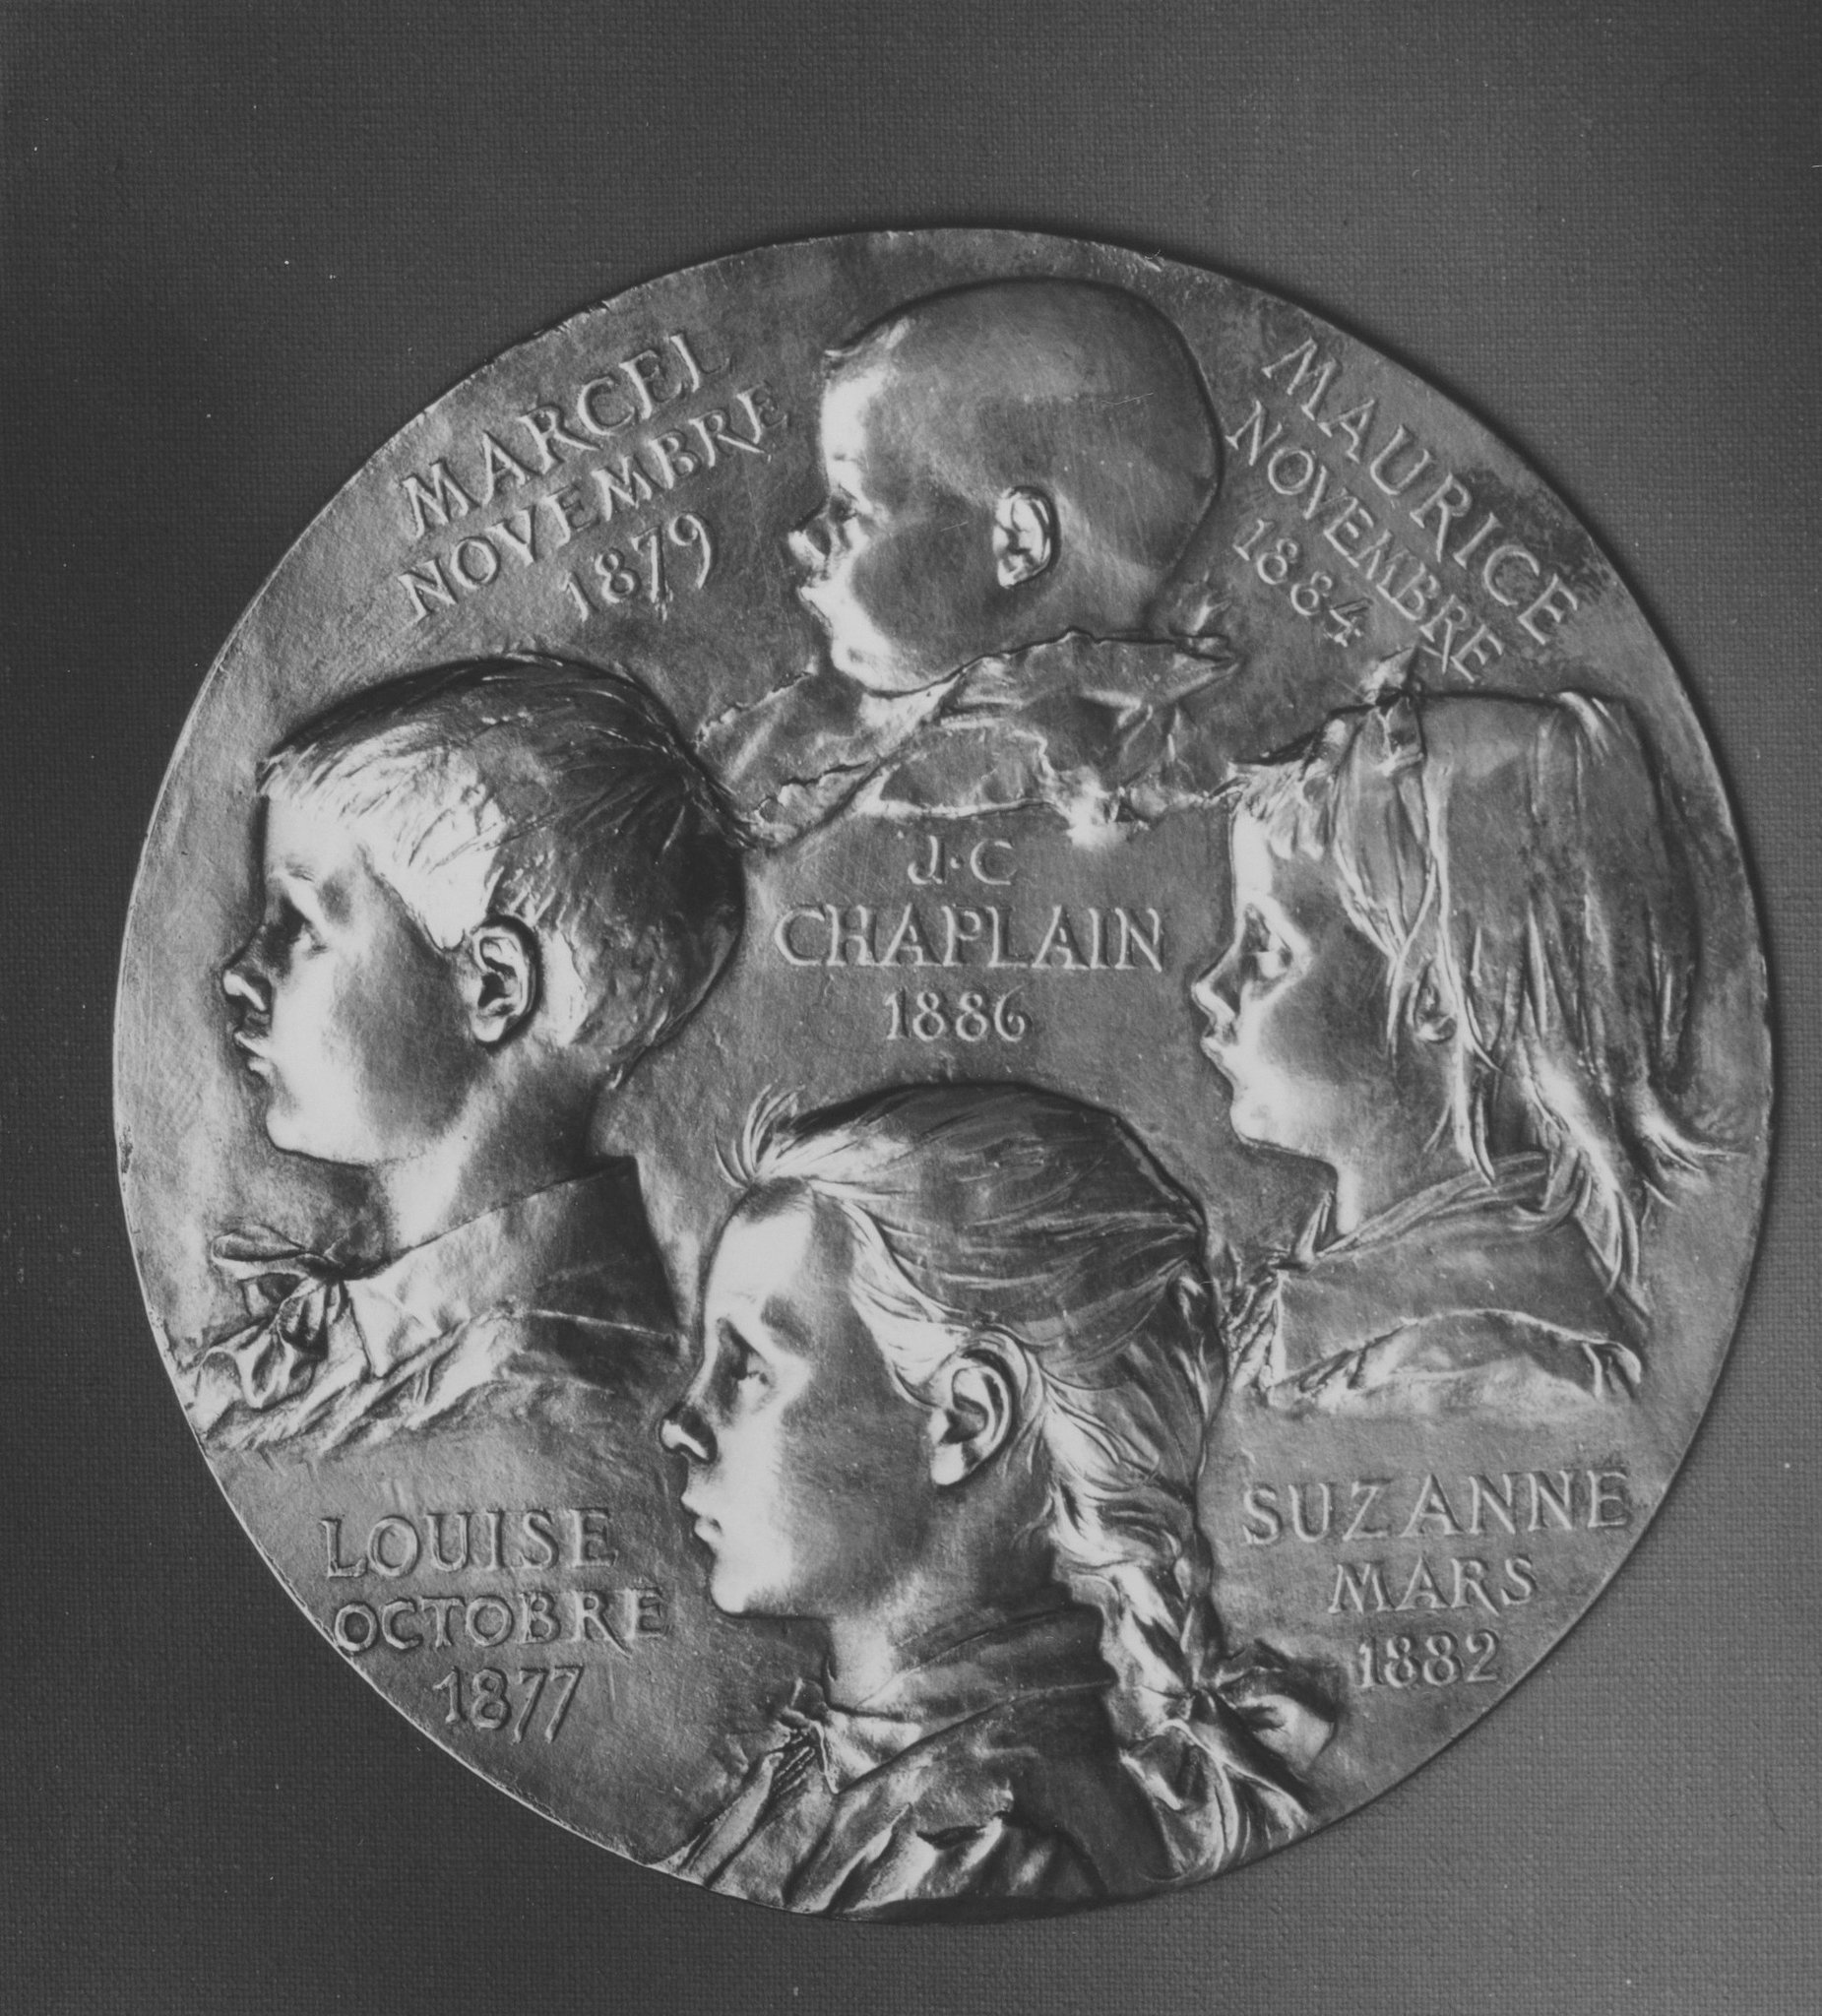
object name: medallion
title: The Artist's Children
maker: jules-clément chaplain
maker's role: artist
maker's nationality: french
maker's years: 1839-1909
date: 1886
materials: bronze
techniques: casting, silvered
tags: boys,girls,profiles